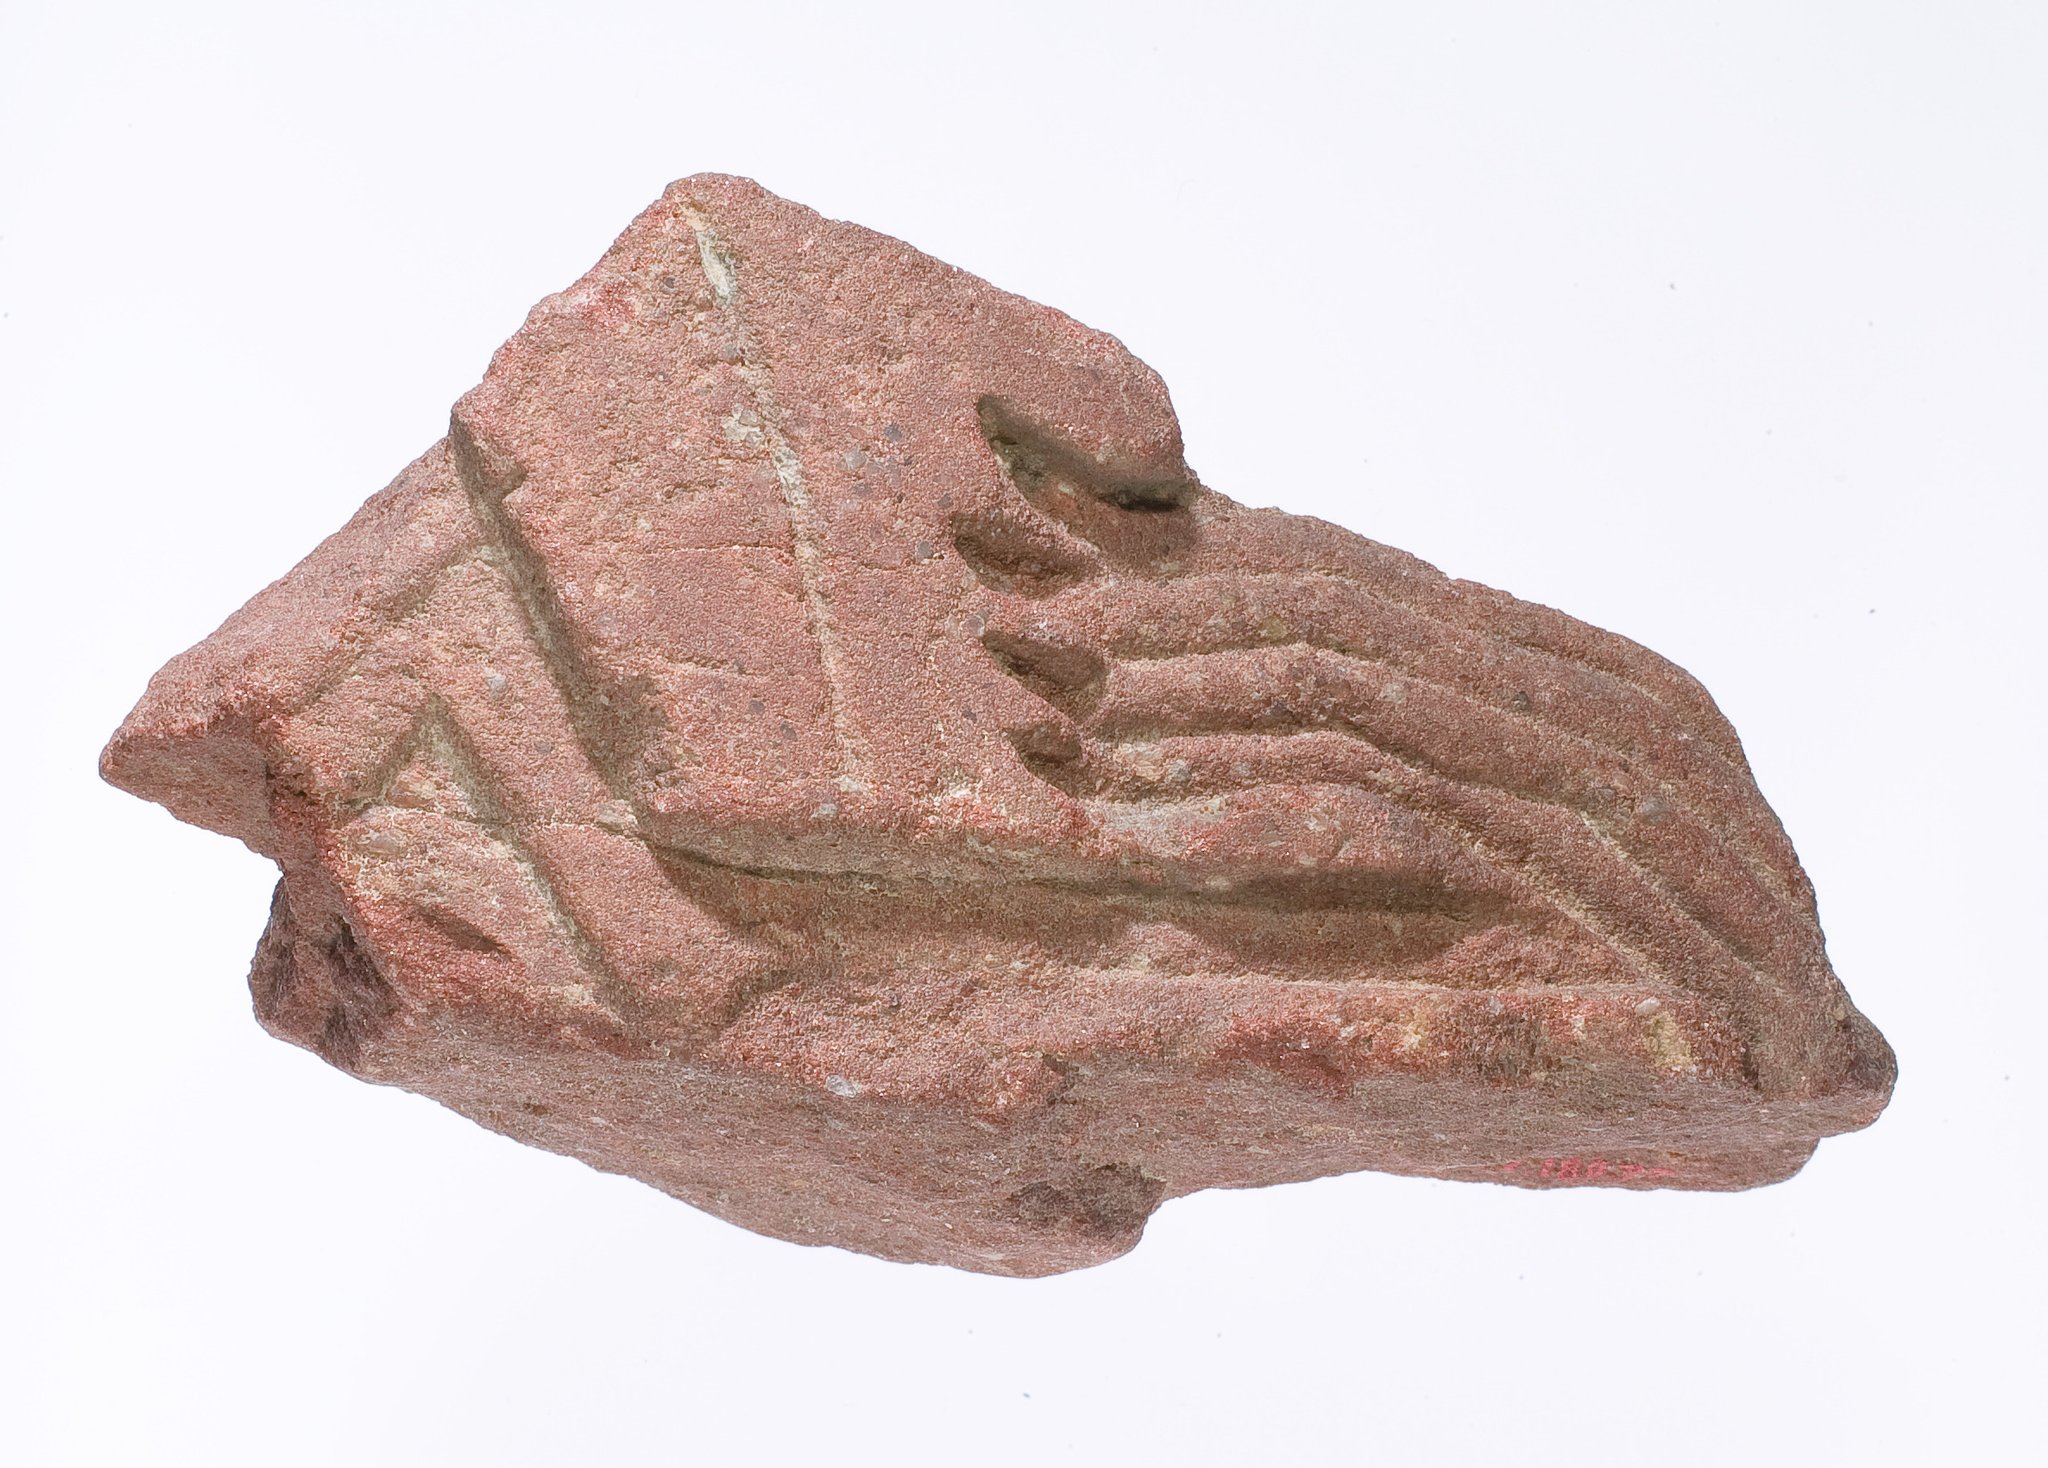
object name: hand casting incense, offering pile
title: Hand casting incense (?) over an offering pile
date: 1353-1336 BCE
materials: quartzite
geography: egypt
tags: hands